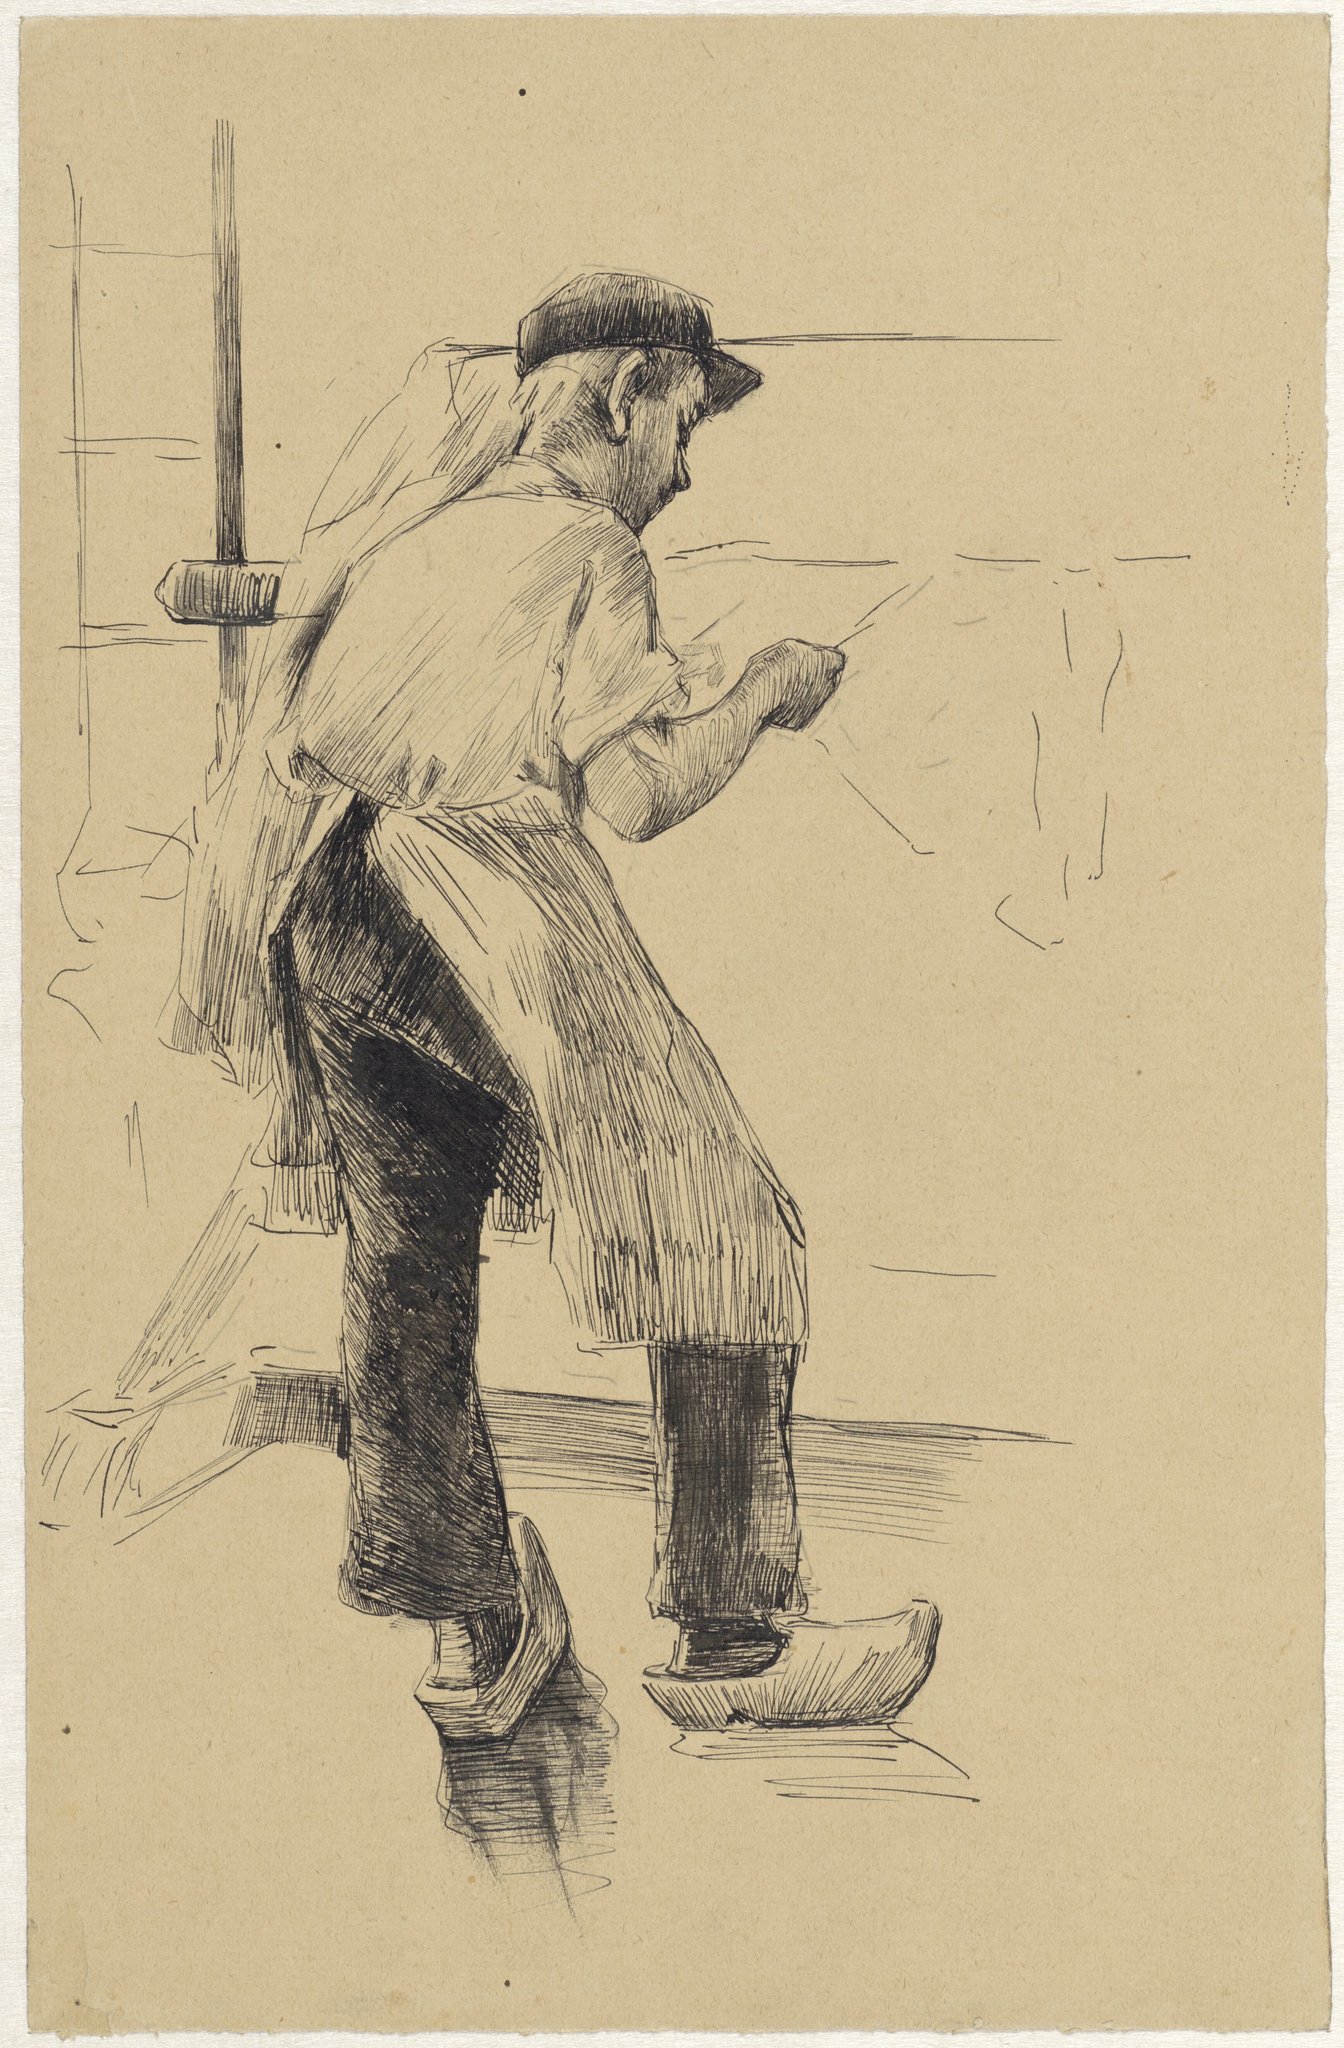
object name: drawing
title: Fabrieksjongen aan het werk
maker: anthon gerhard alexander van rappard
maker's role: draughtsman, print maker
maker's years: 1858-1892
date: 1868-1892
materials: ink, paper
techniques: pen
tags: textile industry and clothing industry